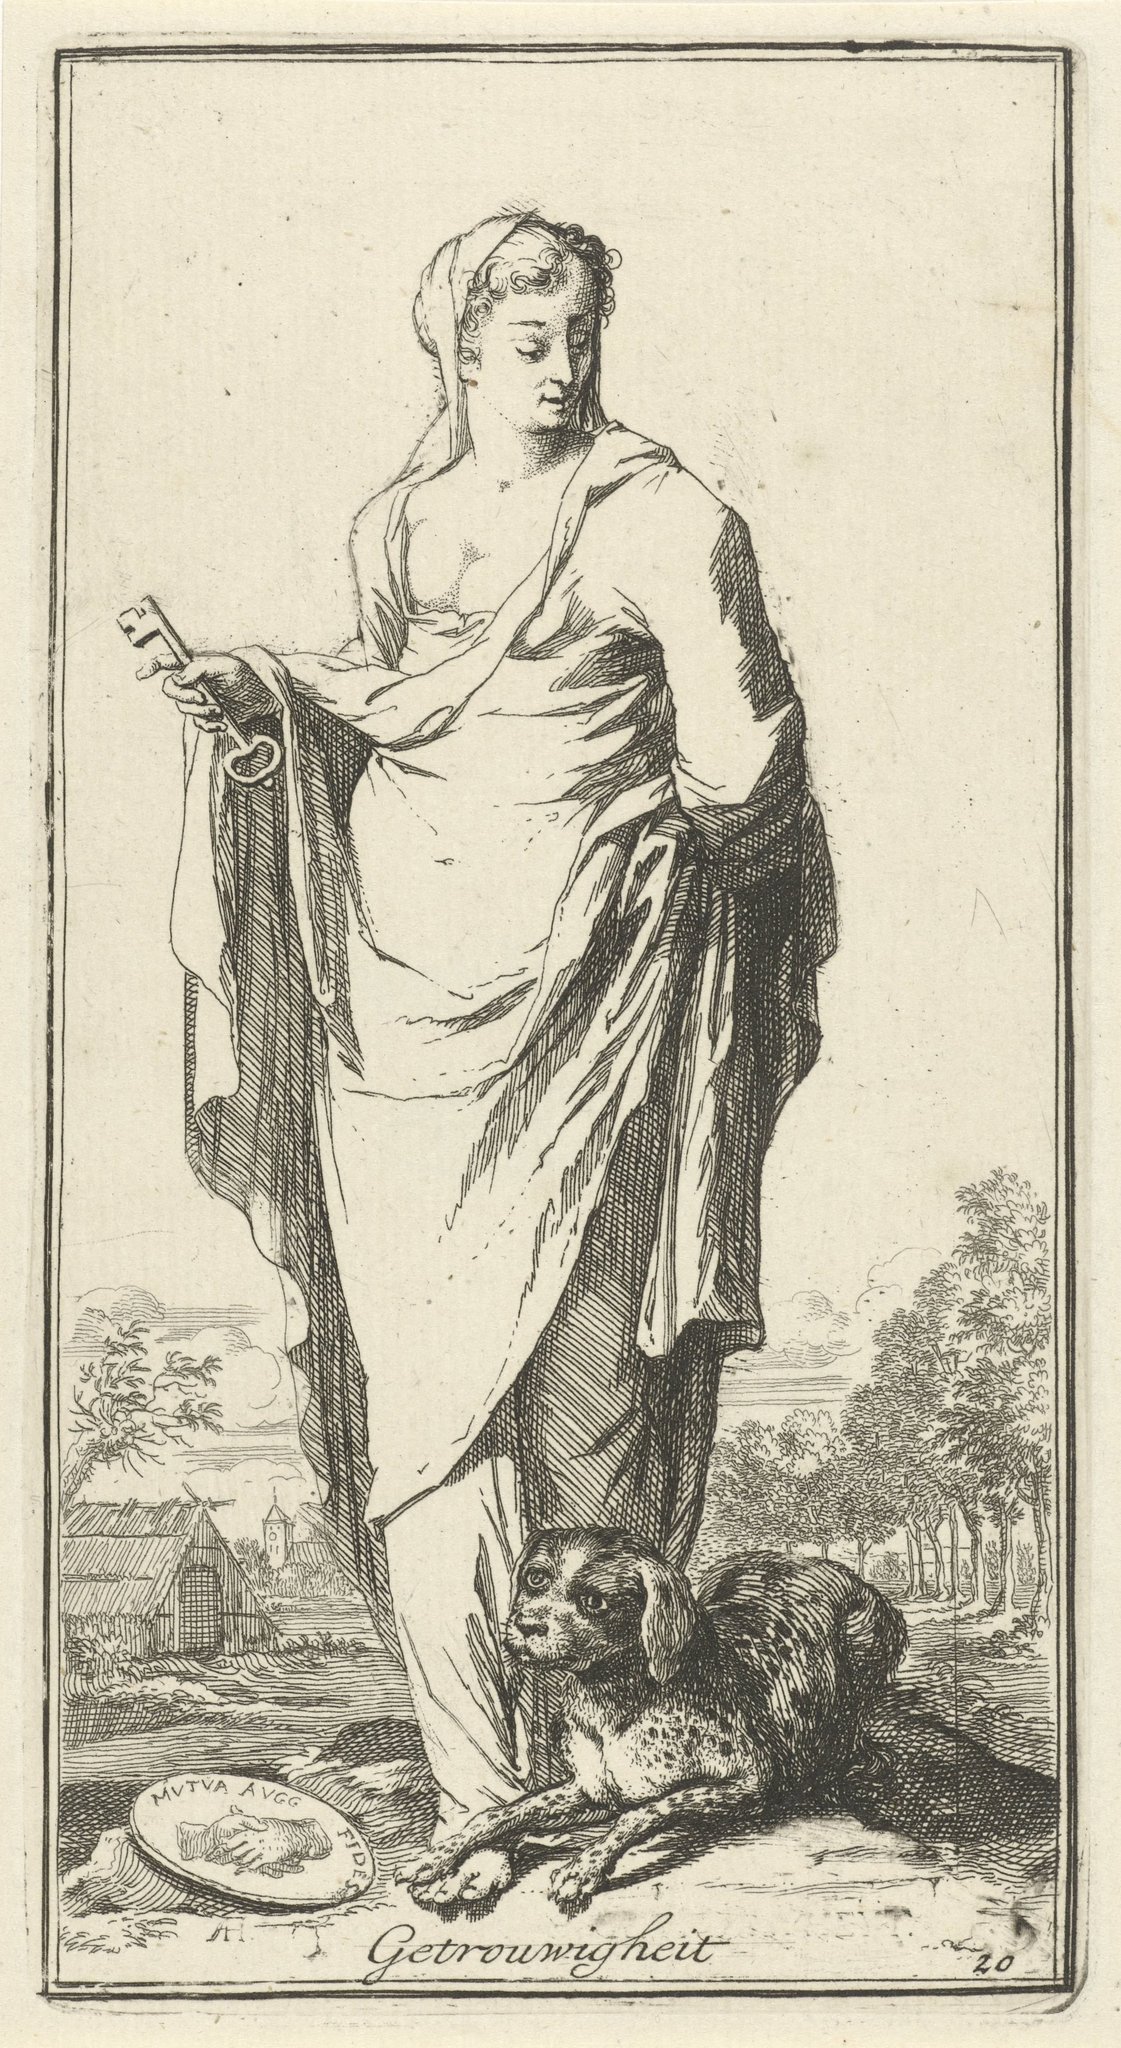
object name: print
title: Een-en-veertigh stuks, verscheydene Sinnebeelden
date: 1710-1719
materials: paper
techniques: etching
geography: amsterdam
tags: faith, 'fides'; 'fede', 'fede catholica', 'fede christiana', 'fede christiana catholica' (ripa) ~ one of the three theological virtues, key, dog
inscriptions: collector's mark: Lugt 2228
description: Een vrouwfiguur als personificatie van trouw met in haar rechterhand een sleutel en aan haar voeten een hond. Links op de voorgrond een medaillon met twee in elkaar geslagen handen en een spreuk in het Latijn. Prent uit een serie van 41 zinnebeelden.